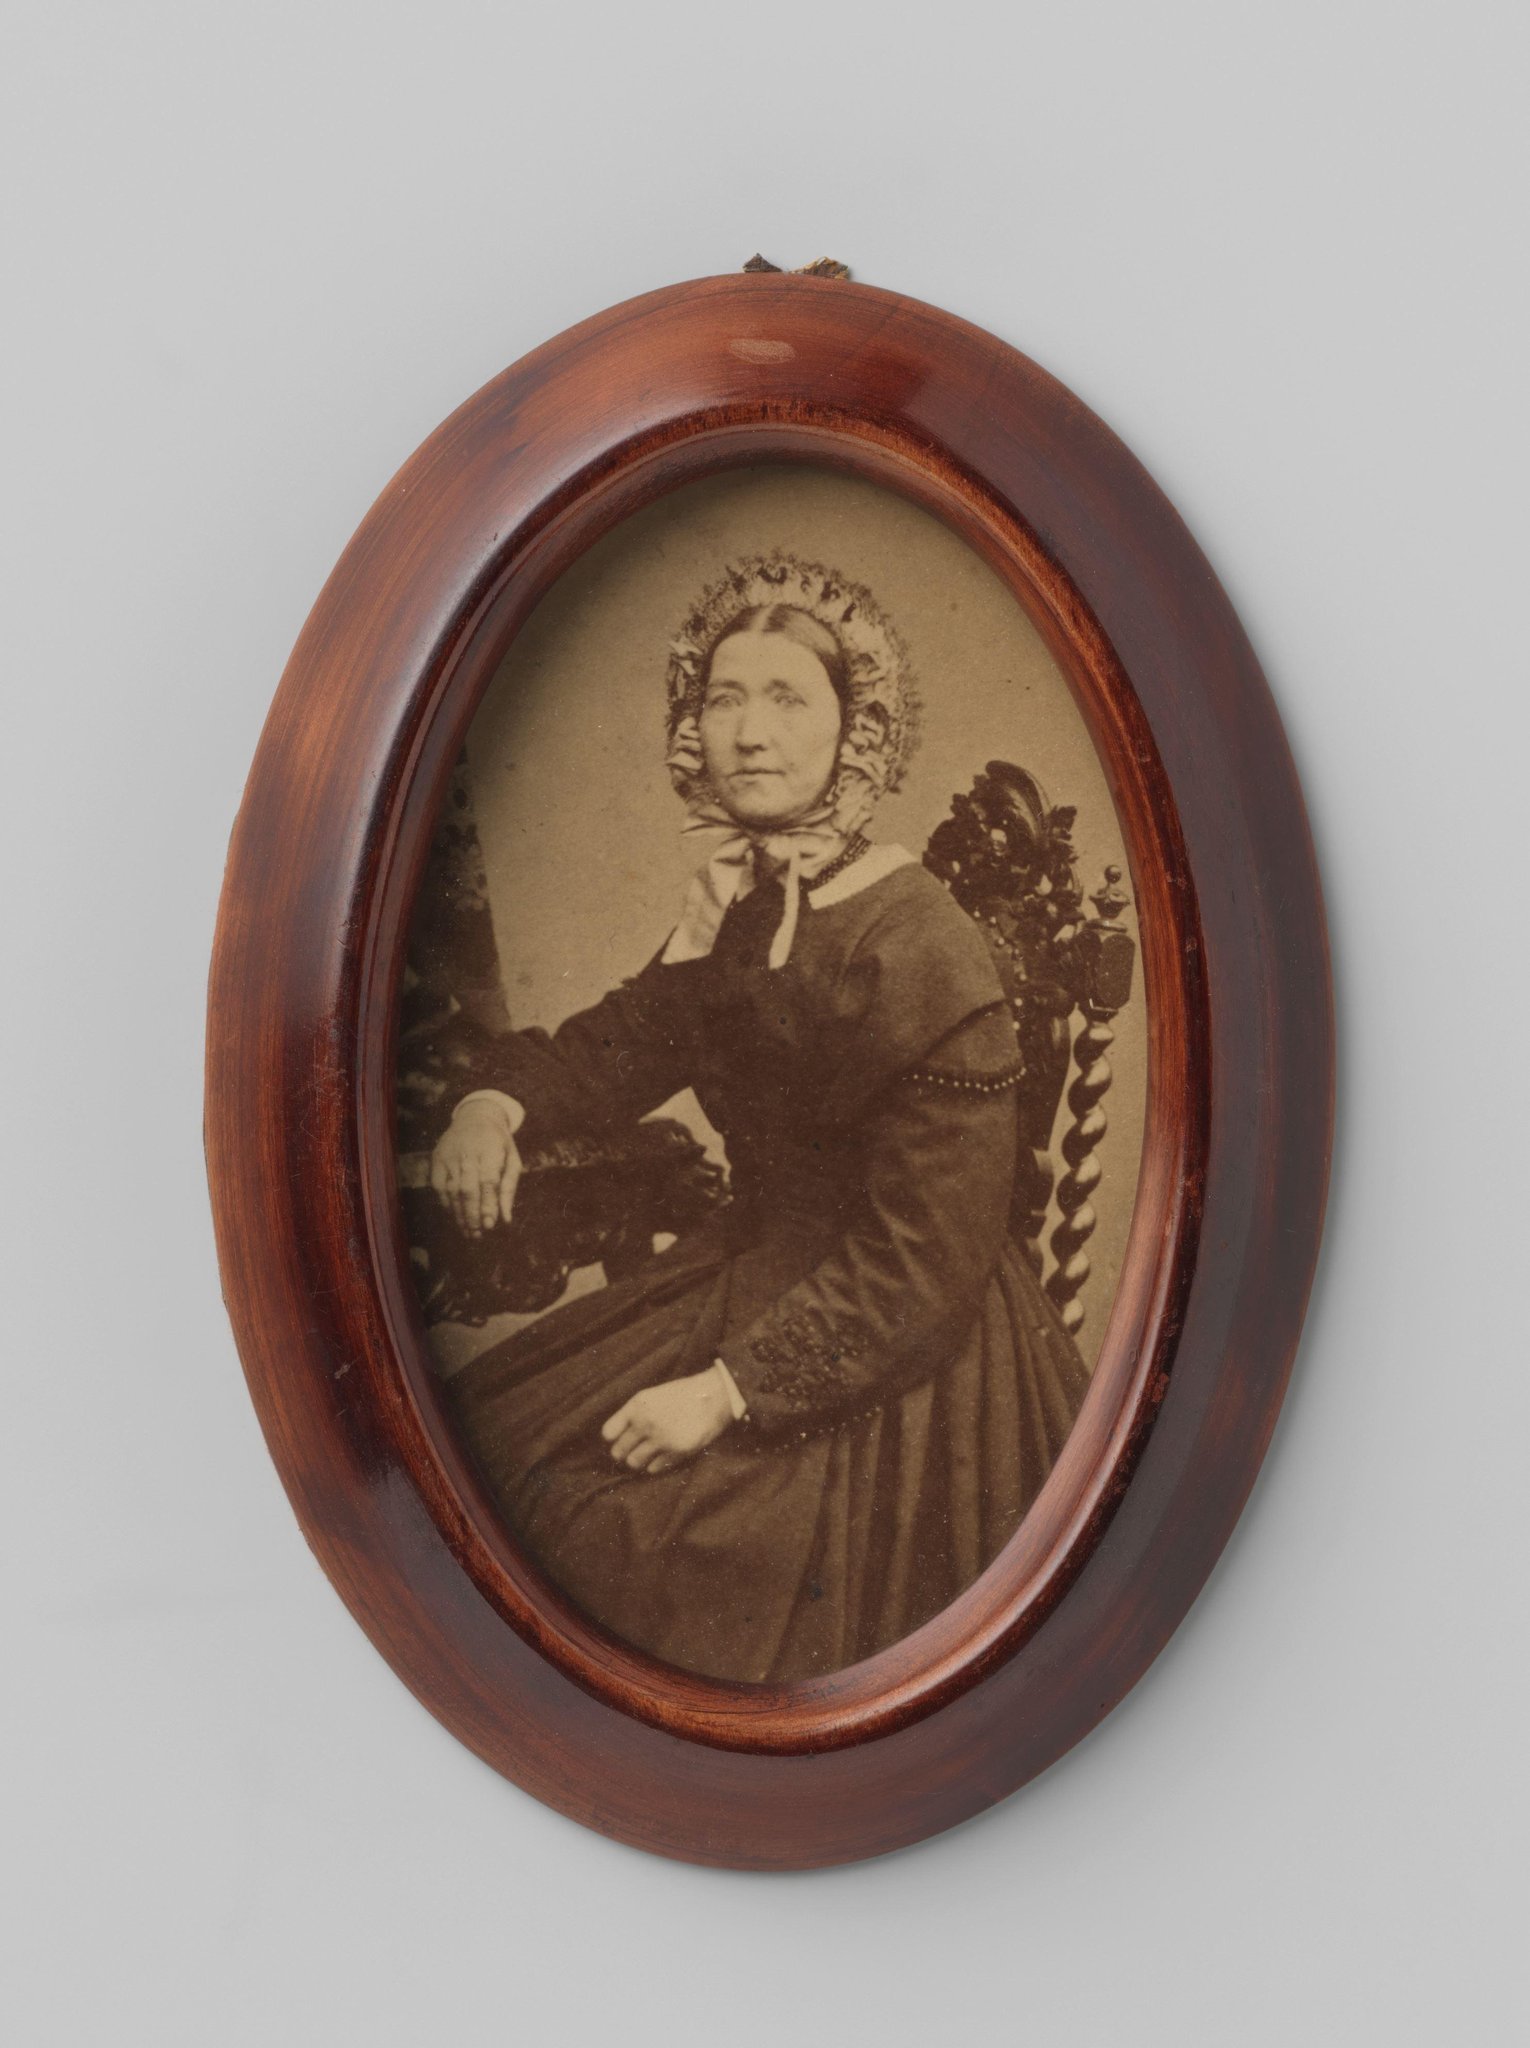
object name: photograph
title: Portret van een onbekende zittende vrouw met muts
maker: Anonymous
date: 1880-1900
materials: glass, metal, paper, wood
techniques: albumen print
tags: sitting figure, head-gear: cap, anonymous historical person portrayed - bb - woman